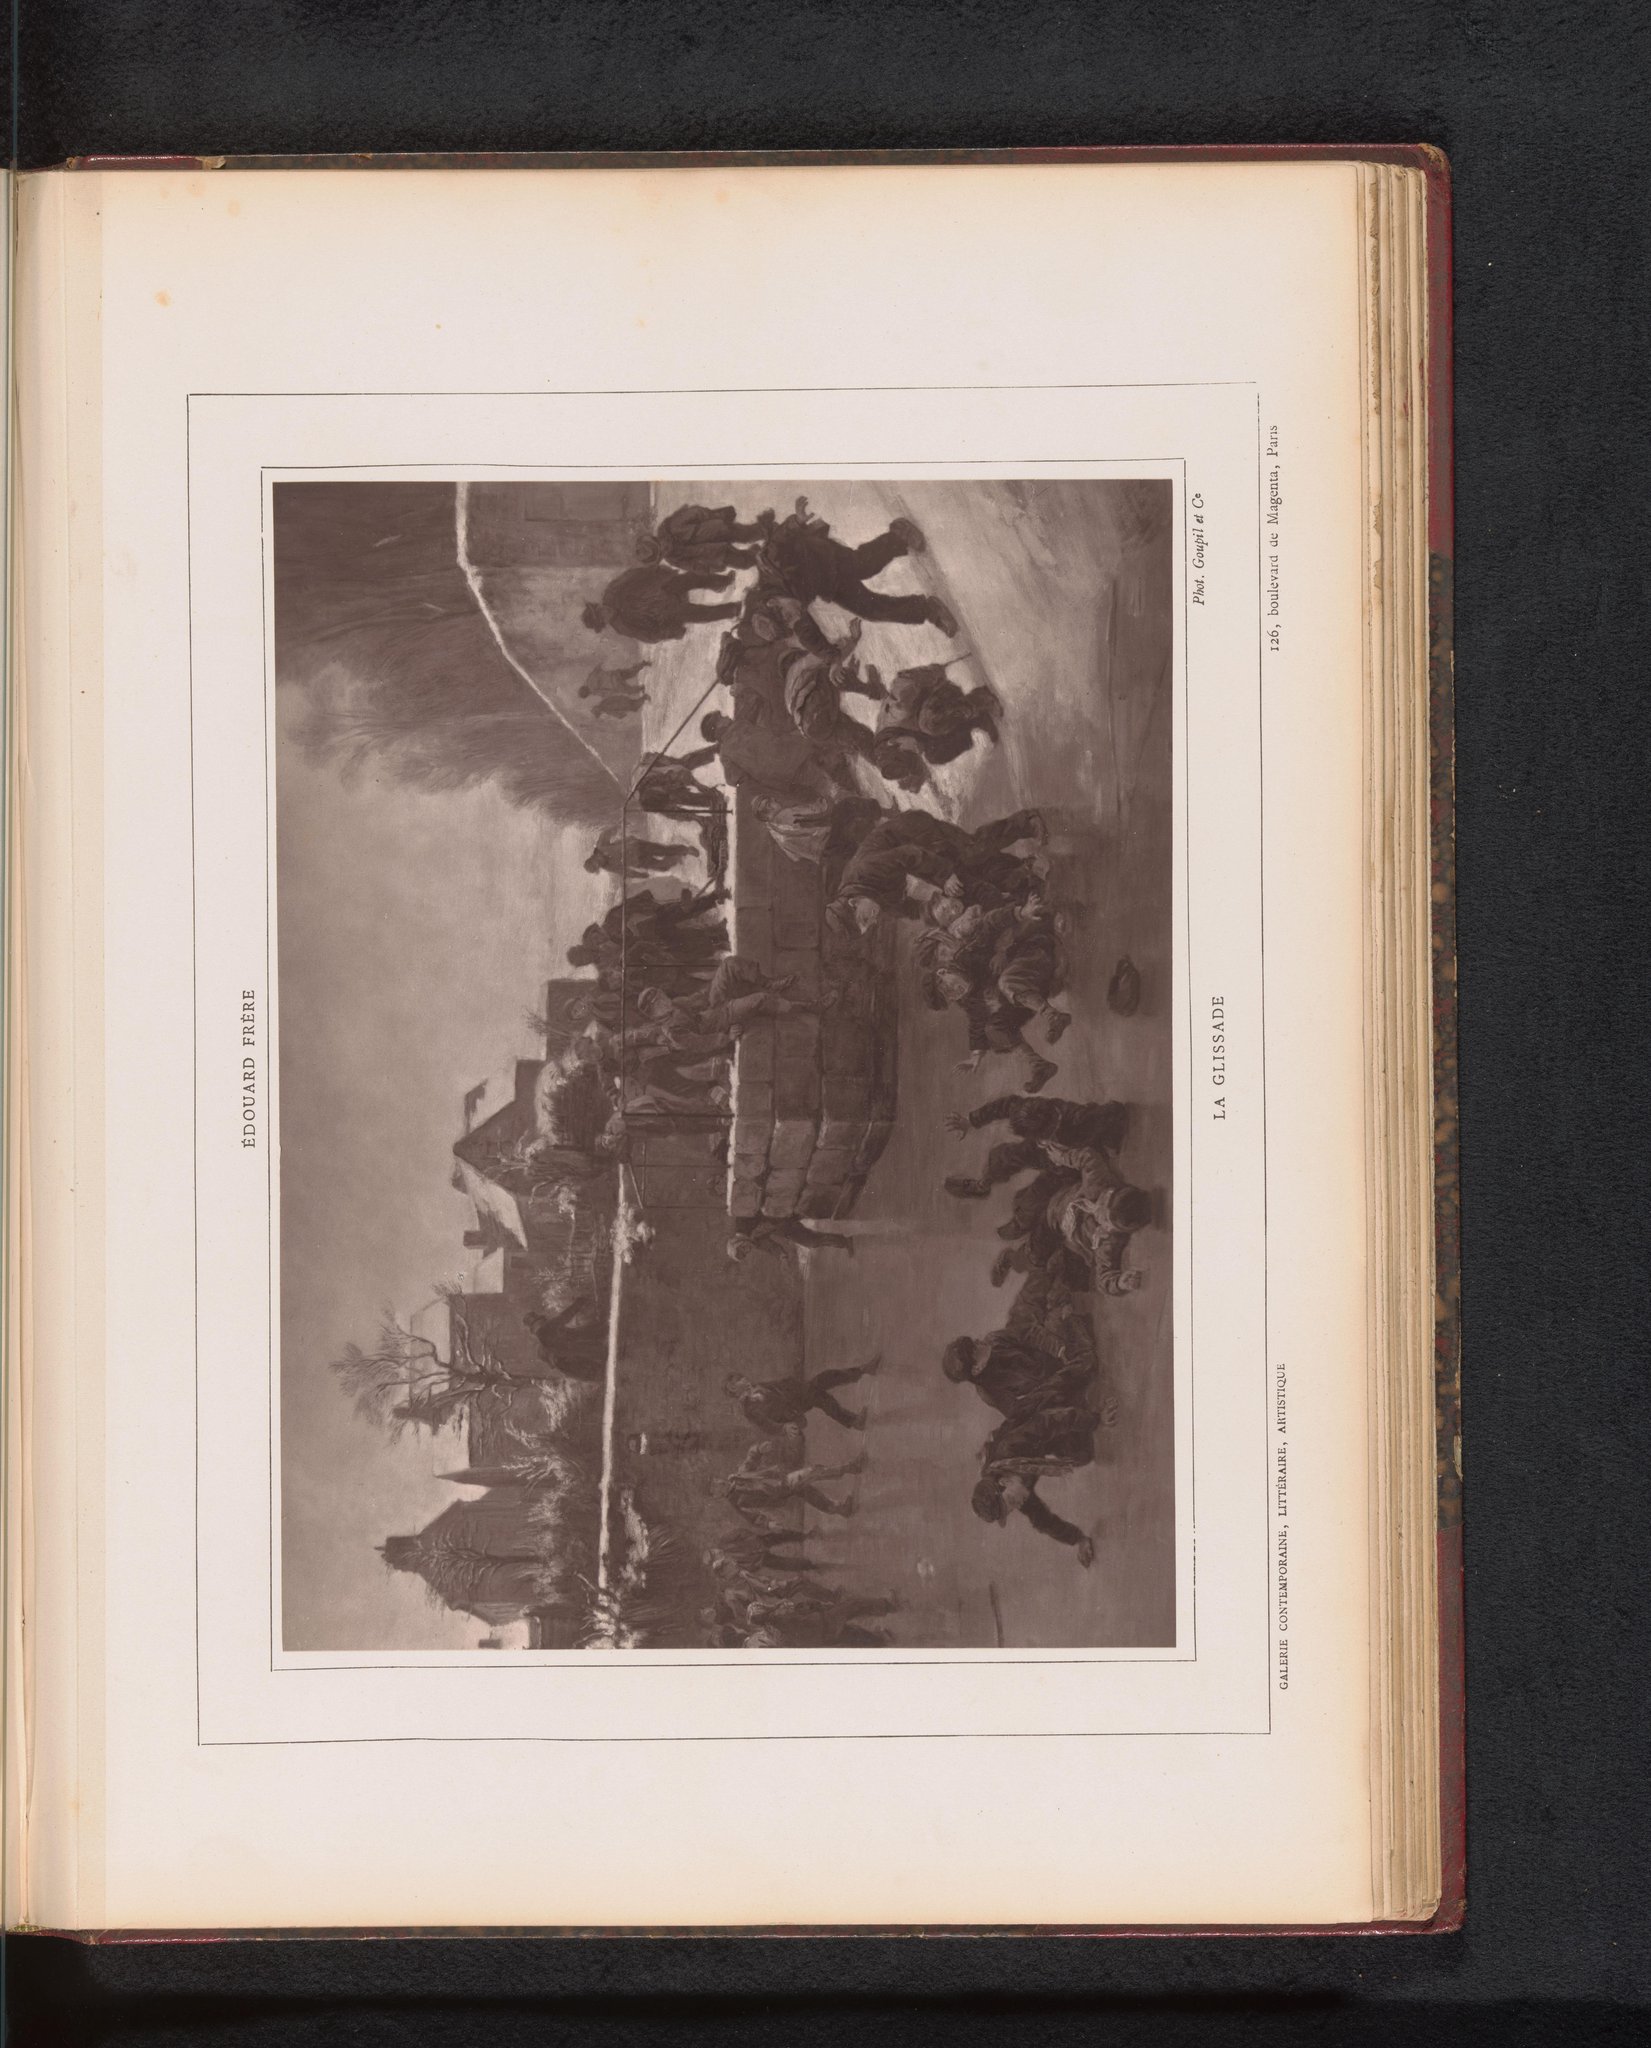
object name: page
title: Reproductie van La glissade door Pierre Edouard Frère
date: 1871-1876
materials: paper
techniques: woodburytype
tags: boy (child between toddler and youth), child and nature (games and plays), painting, drawing and the graphic arts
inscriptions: inscription: ‘Galerie Contemporaine, Littéraire, Artistique/ 126, boulevard de Magenta, Paris’